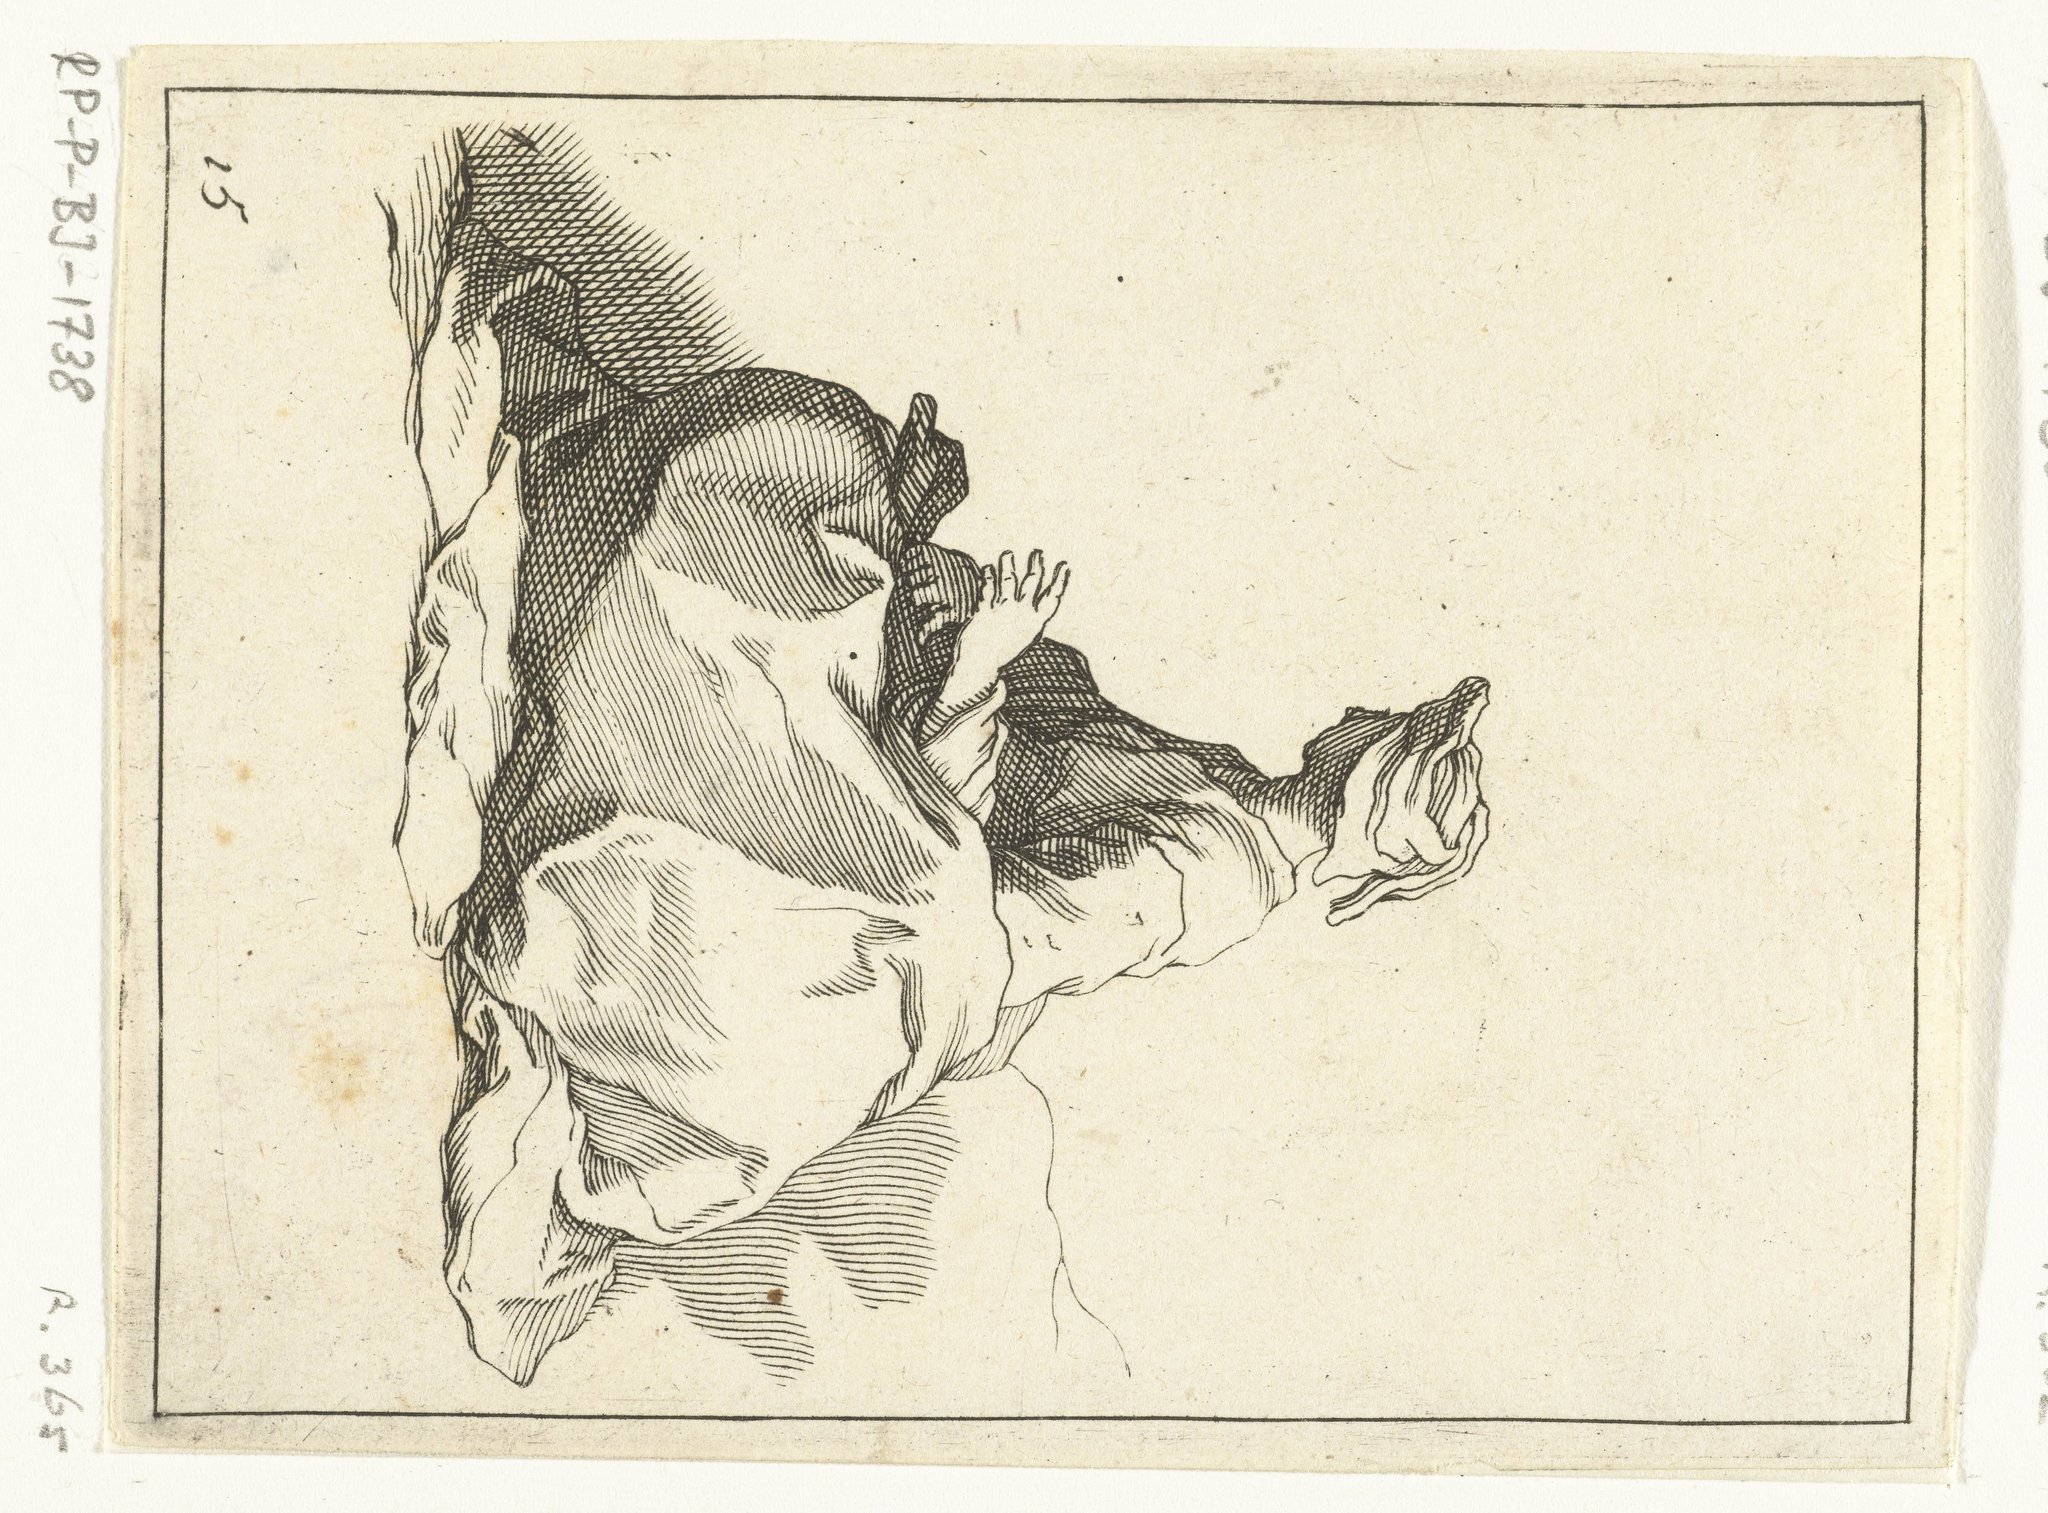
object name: print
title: Zittende jonge vrouw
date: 1635-1669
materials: paper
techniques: engraving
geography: utrecht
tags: adult woman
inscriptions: collector's mark: Lugt 240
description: Zittende vrouw met hoed en ruimvallende rok, zijwaarts afgebeeld.